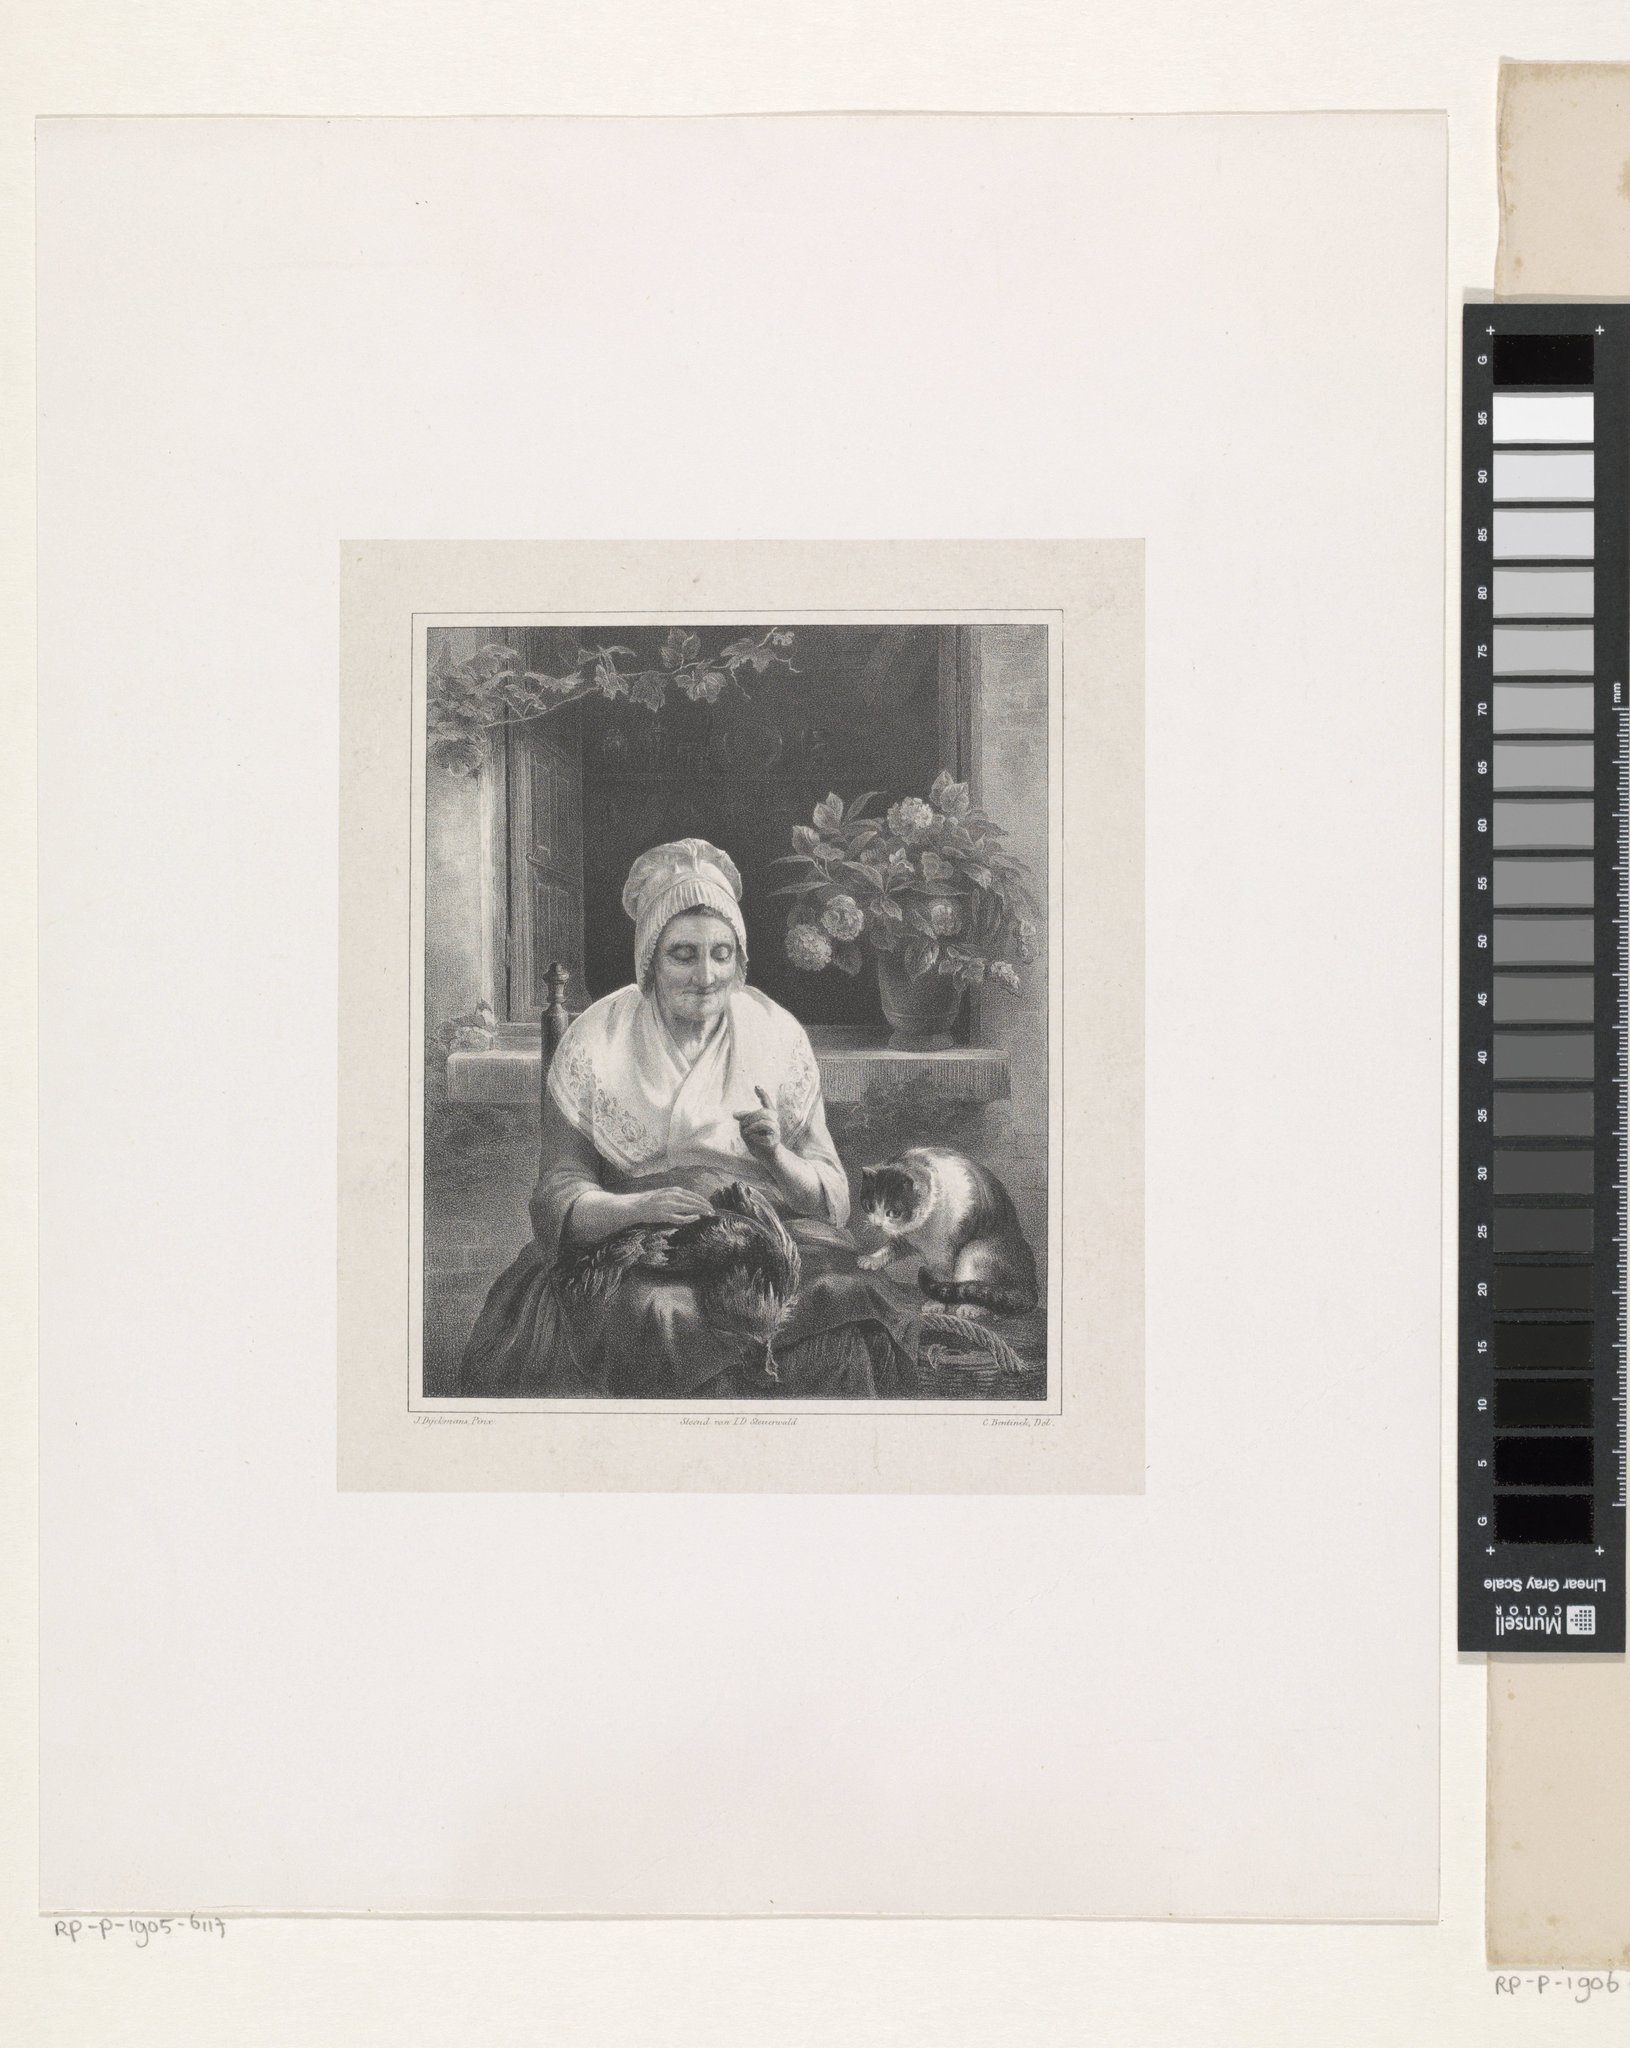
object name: print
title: Oude vrouw met dode kip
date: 1824-1849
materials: paper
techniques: lithograph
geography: netherlands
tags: cat, plucked fowl - cc - in the open air, old woman, open window, flowers in a vase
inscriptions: collector's mark: Lugt 2228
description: De vrouw zit voor een raam en pluk een kip op haar schoot. Naast haar zit een kat. Op de vensterbank staat een bos bloemen in een vaas.